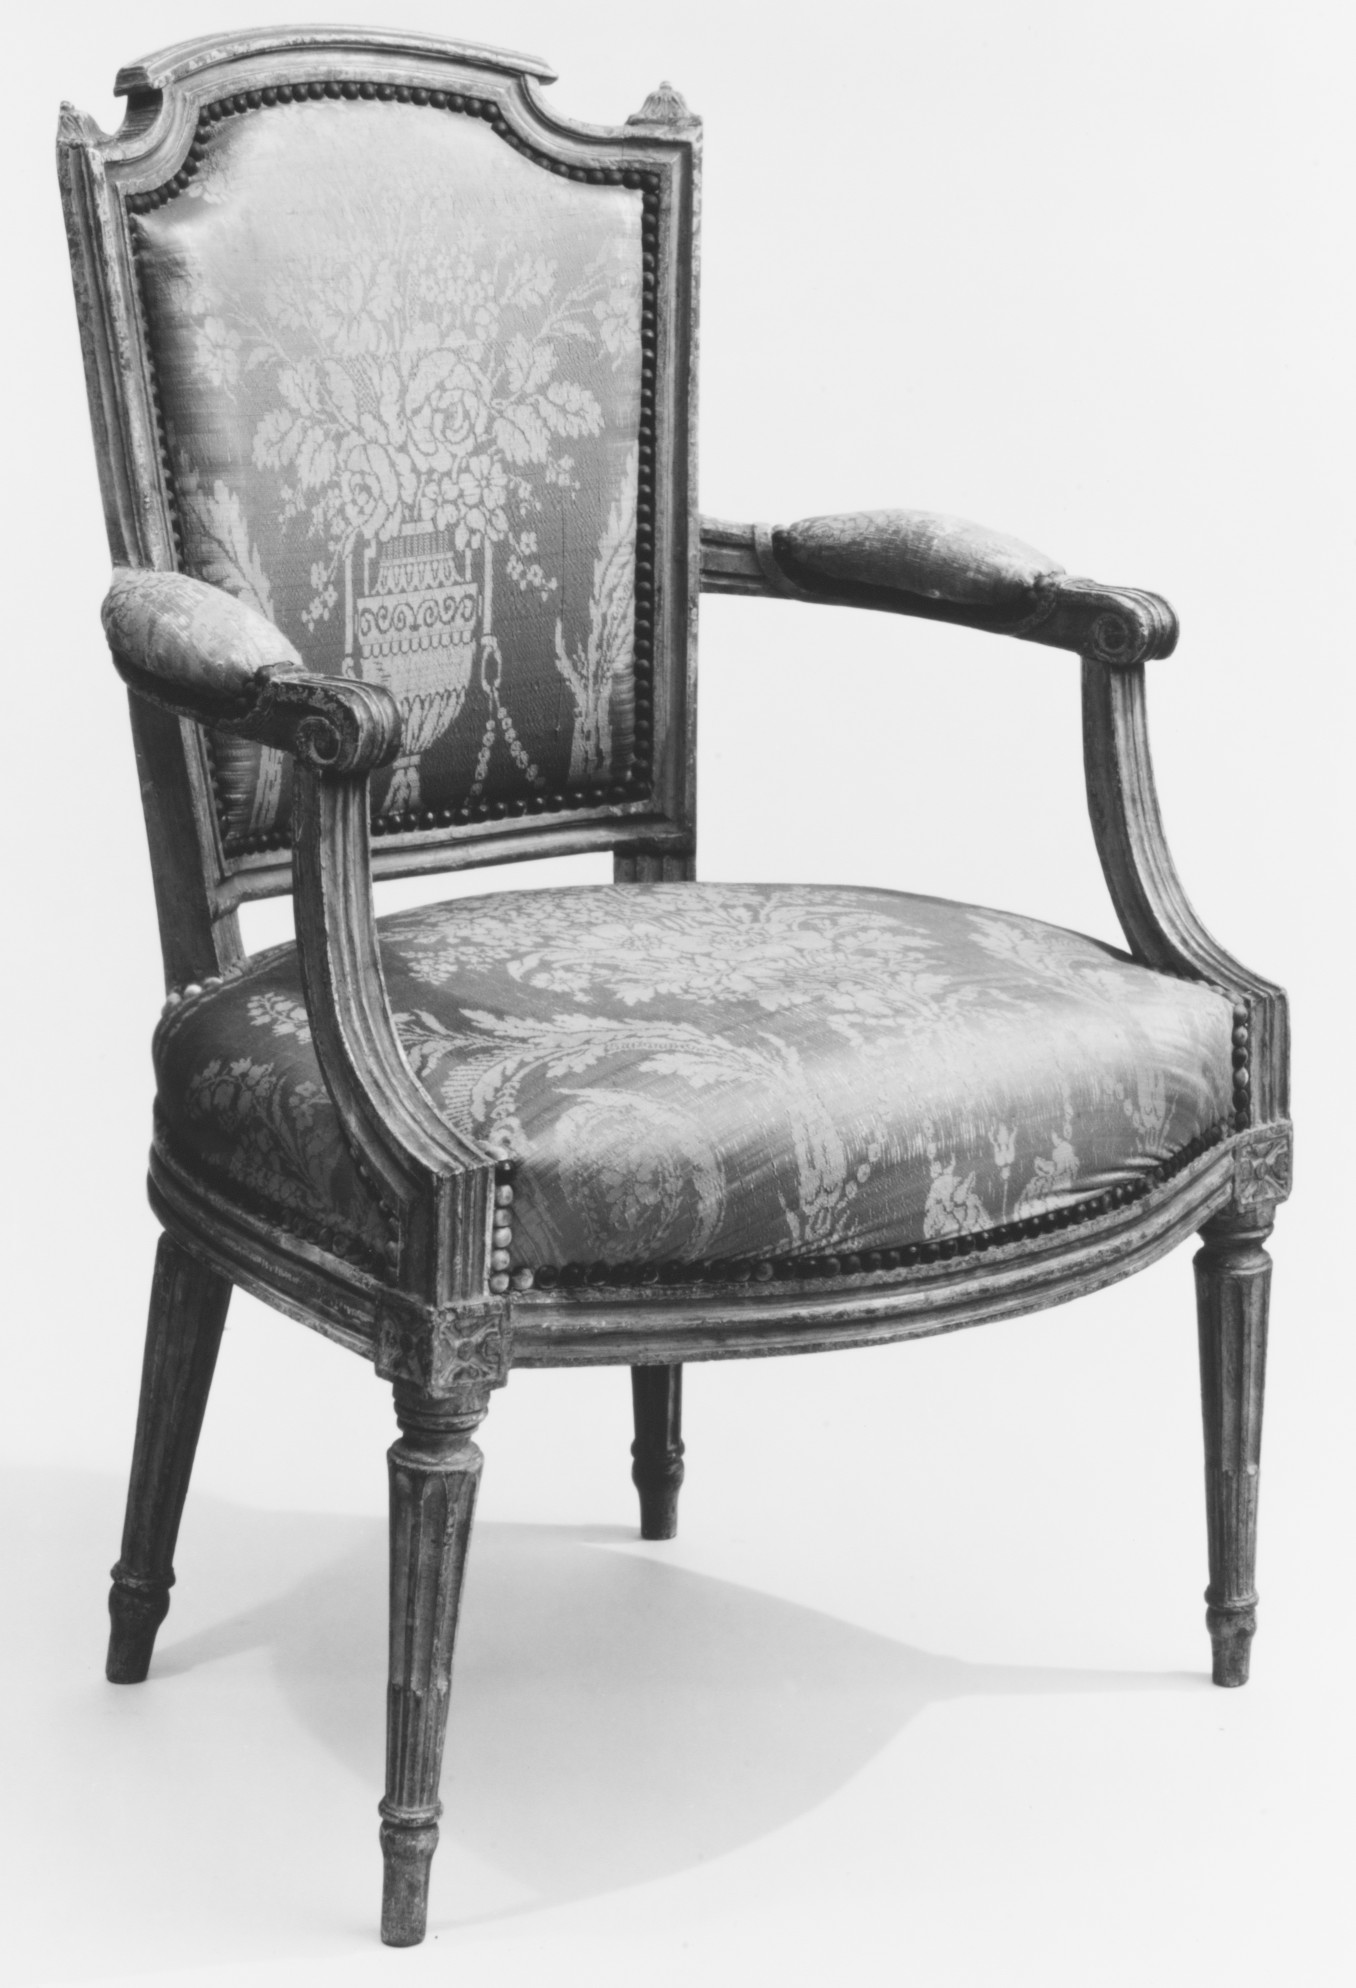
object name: armchair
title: Pair of armchairs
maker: nicolas delaporte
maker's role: maker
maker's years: 1725-1825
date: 1785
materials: wood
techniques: painting